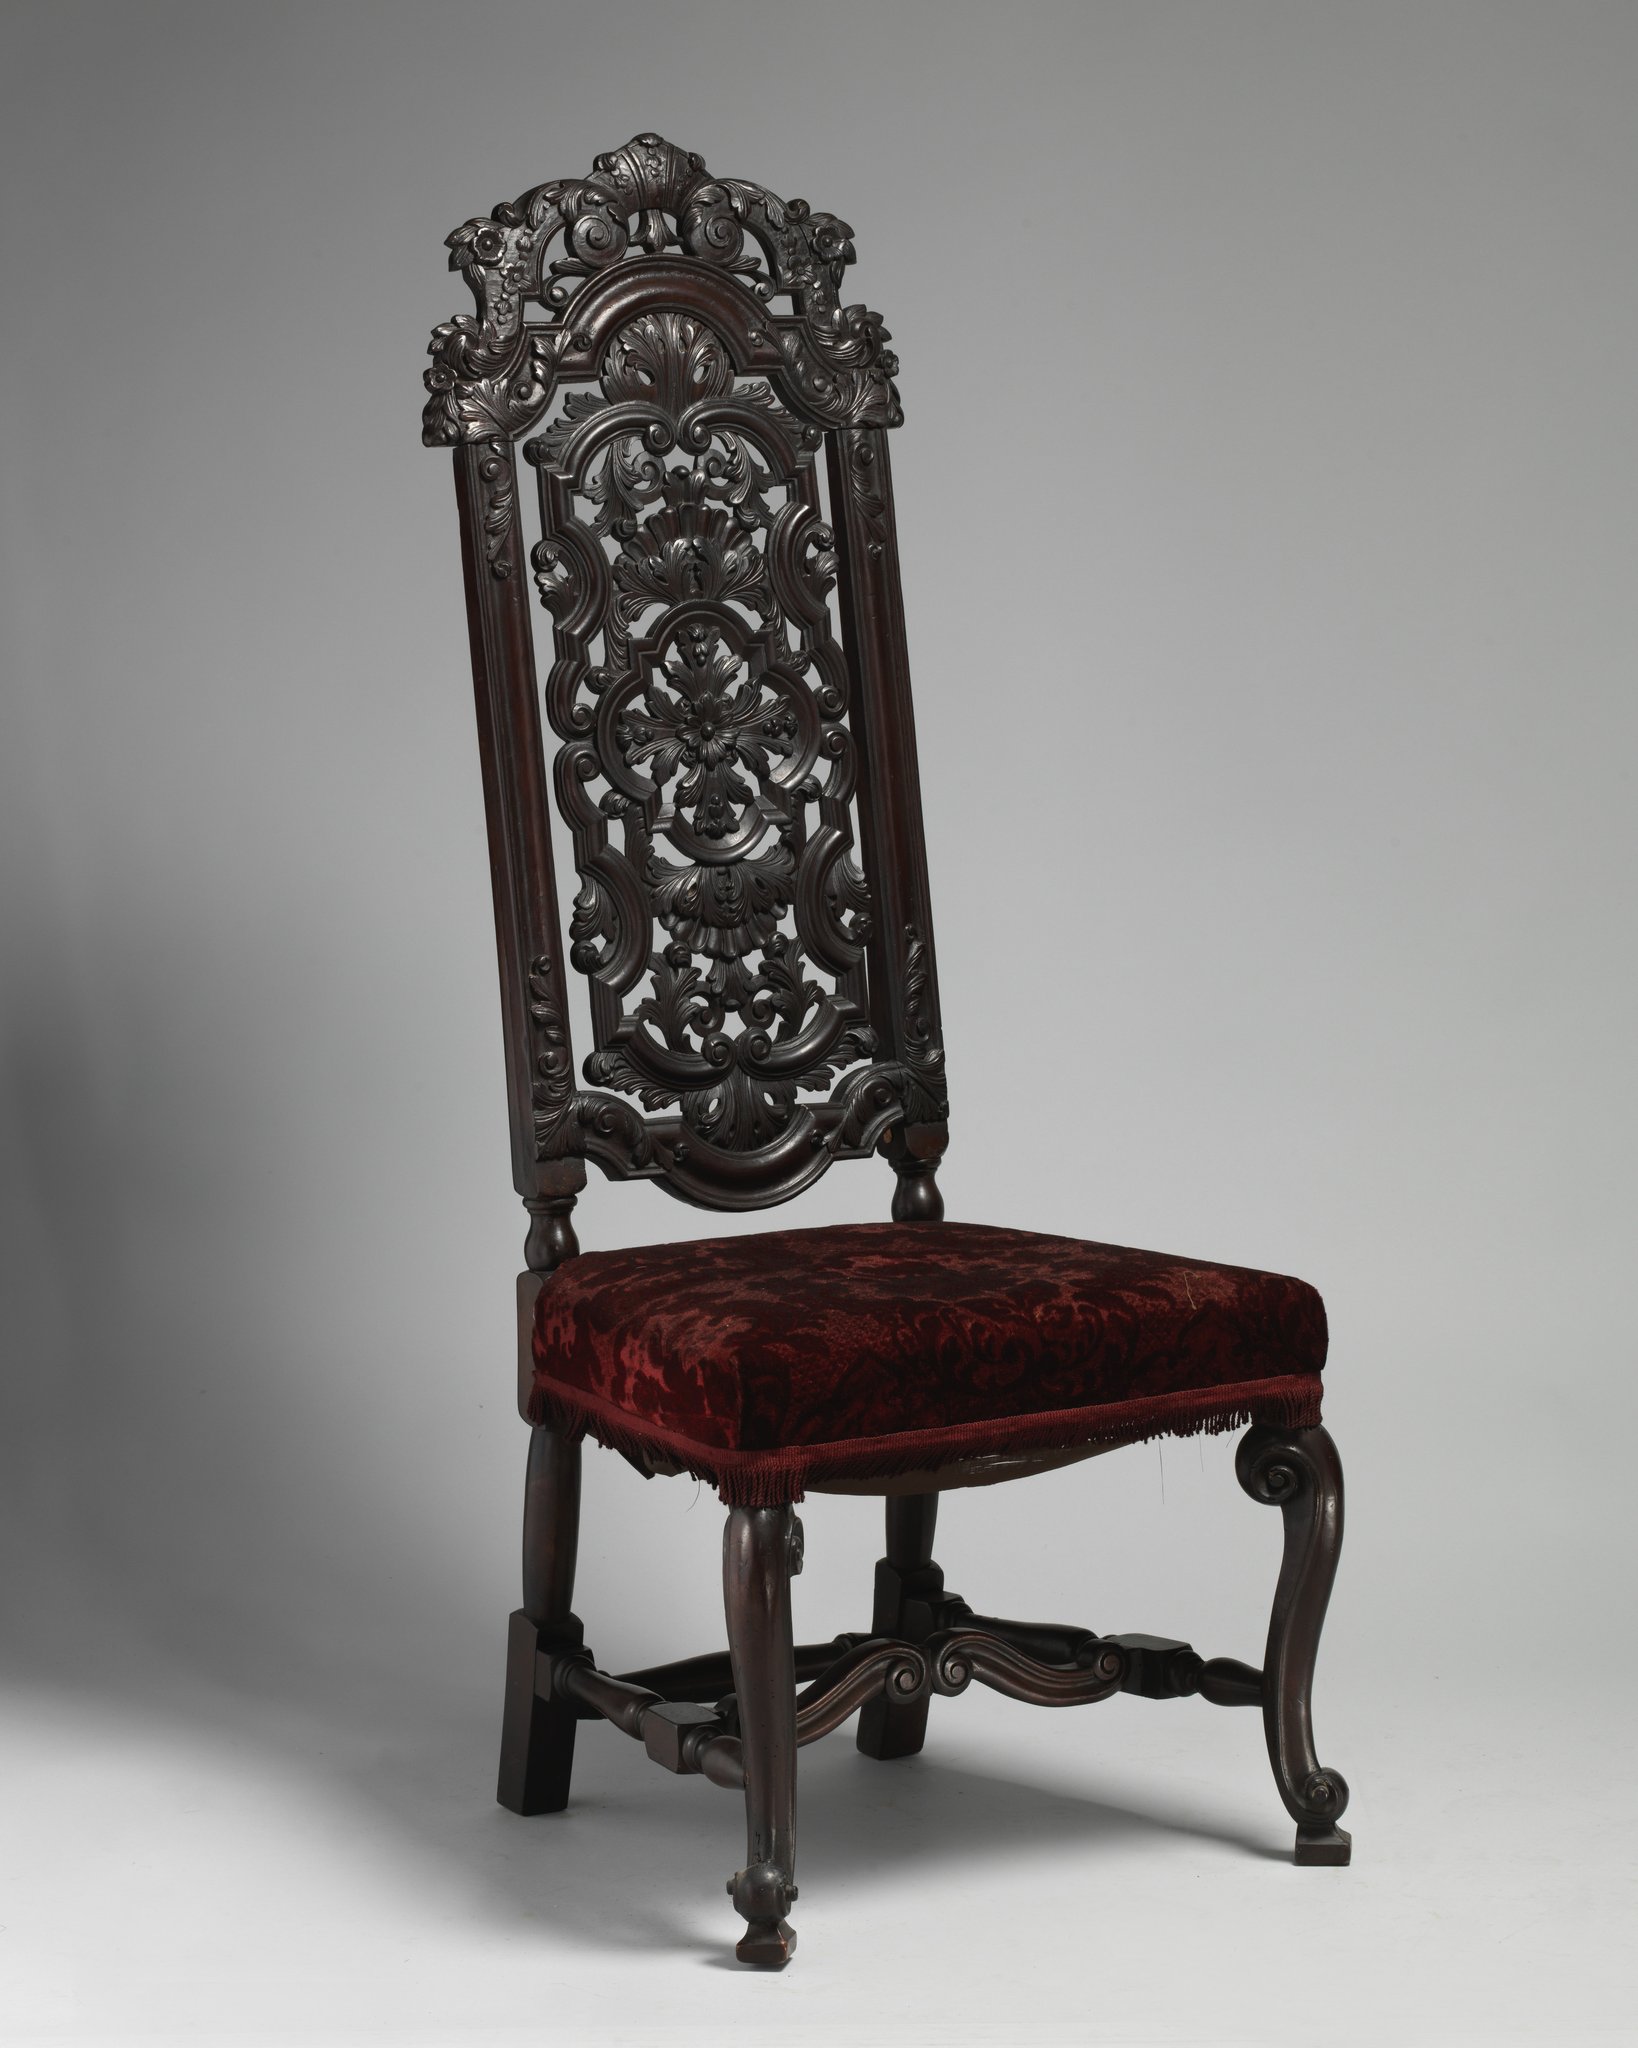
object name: chair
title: Chair (one of a pair)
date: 1688-1702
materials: wood